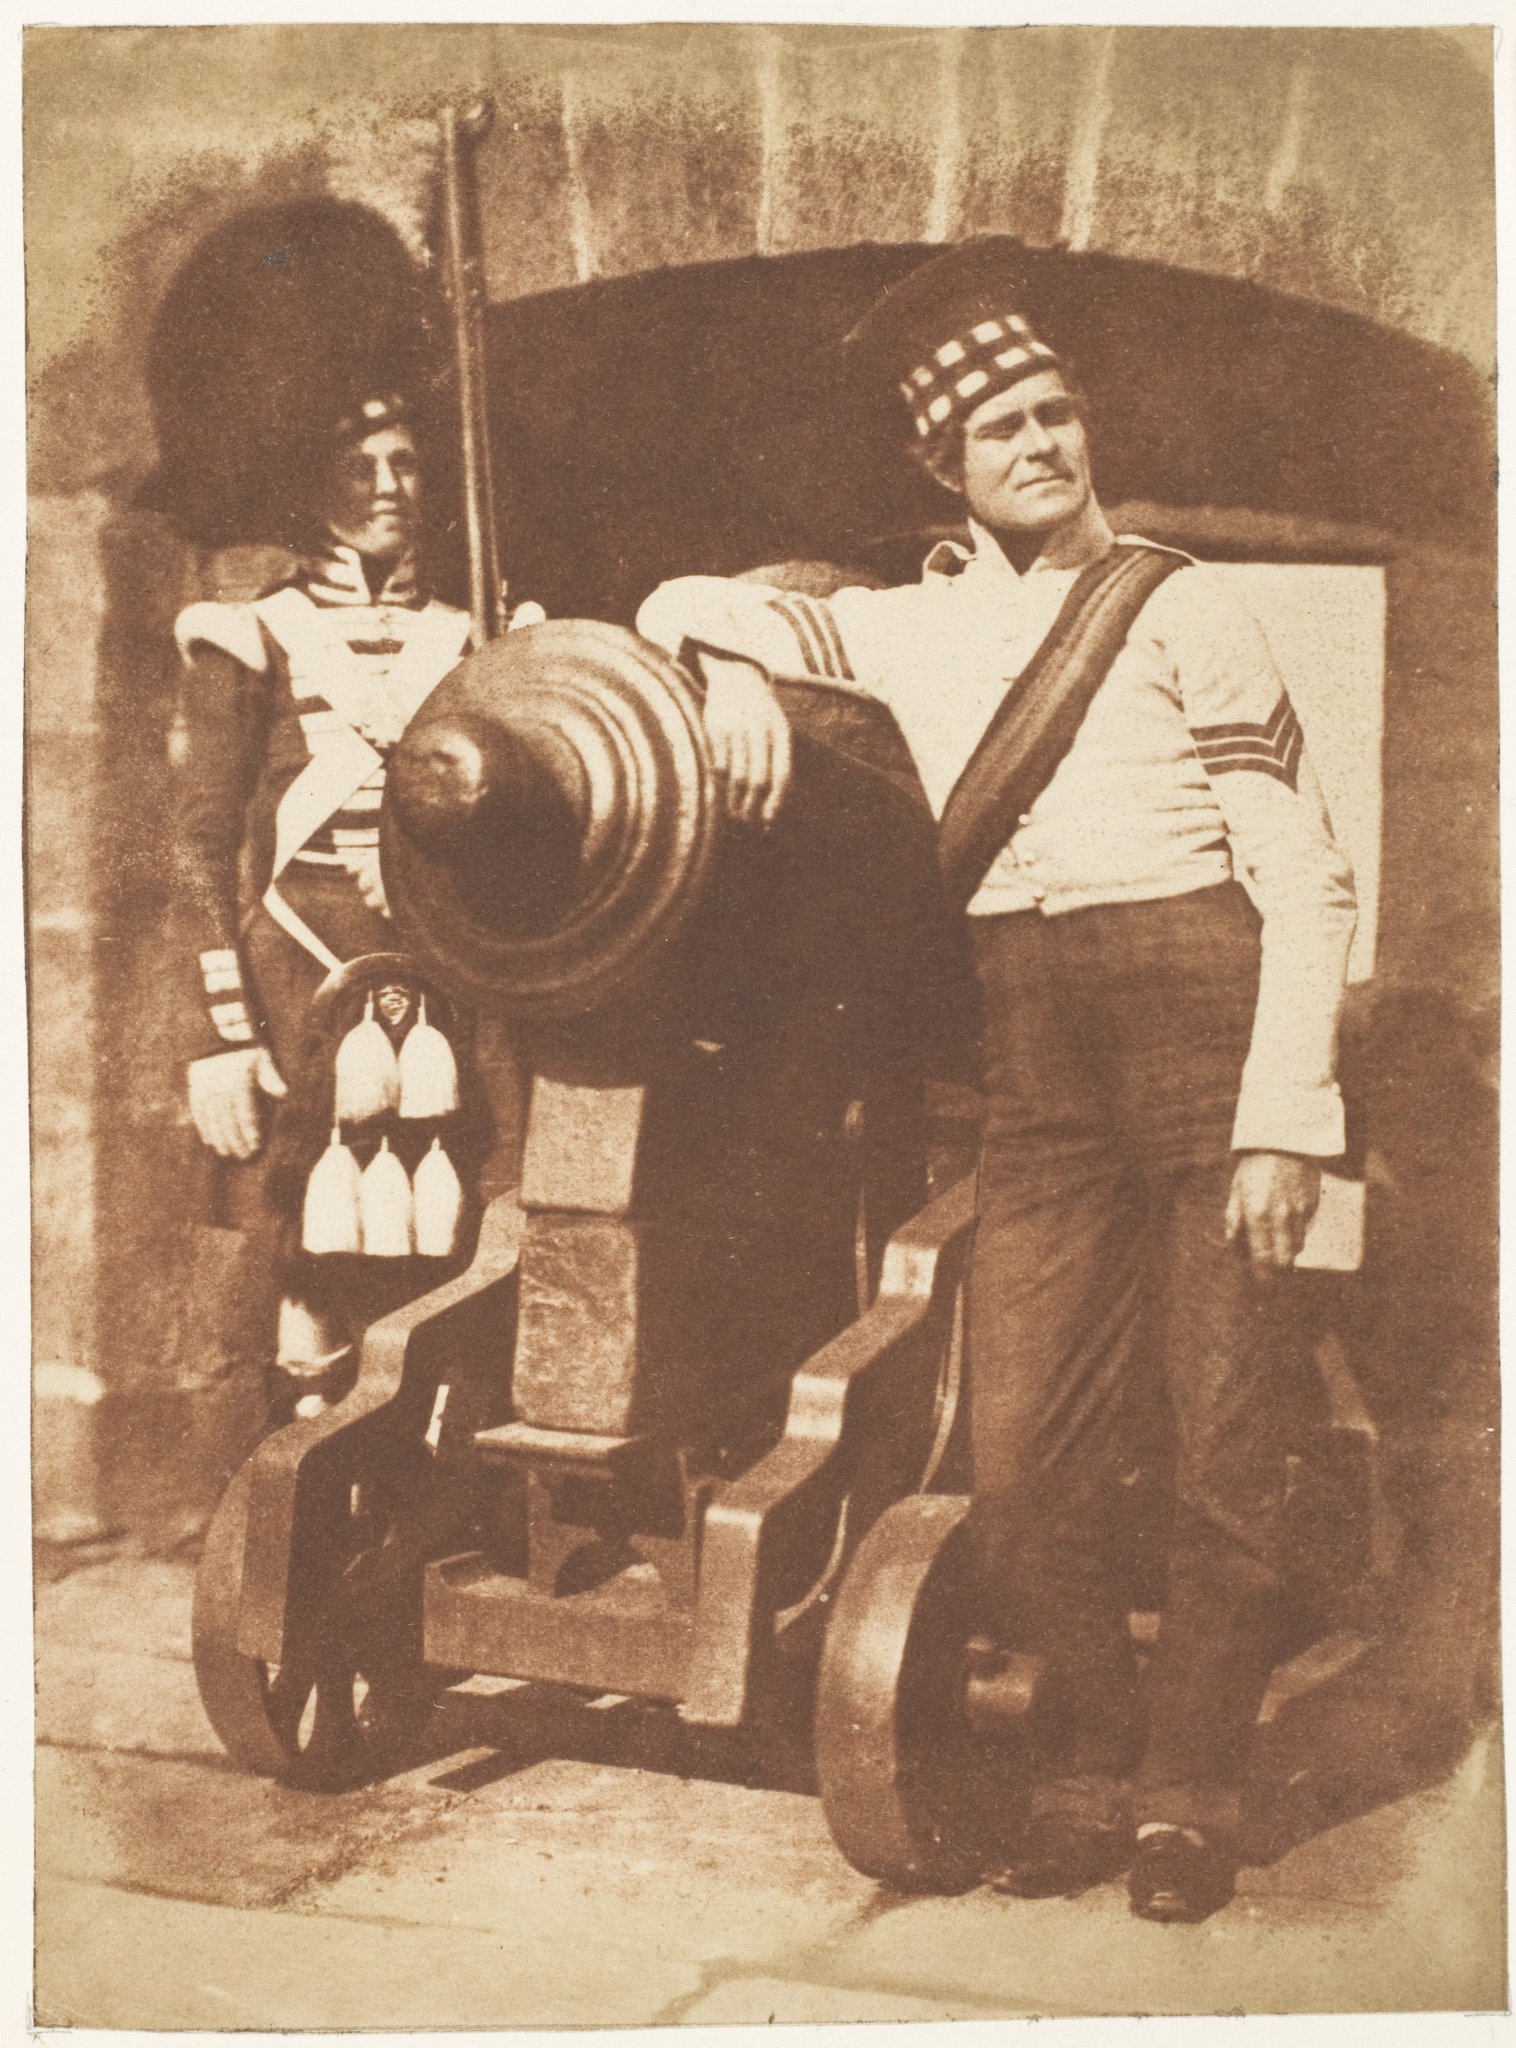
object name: photograph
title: The Porthole / Sergeant and Private of the 42nd Gordon Highlanders, Edinburgh Castle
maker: hill and adamson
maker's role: photography studio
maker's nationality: british, scottish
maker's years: 1843-1848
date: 1843-1847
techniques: paper negative, salted paper print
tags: soldiers,cannons,men